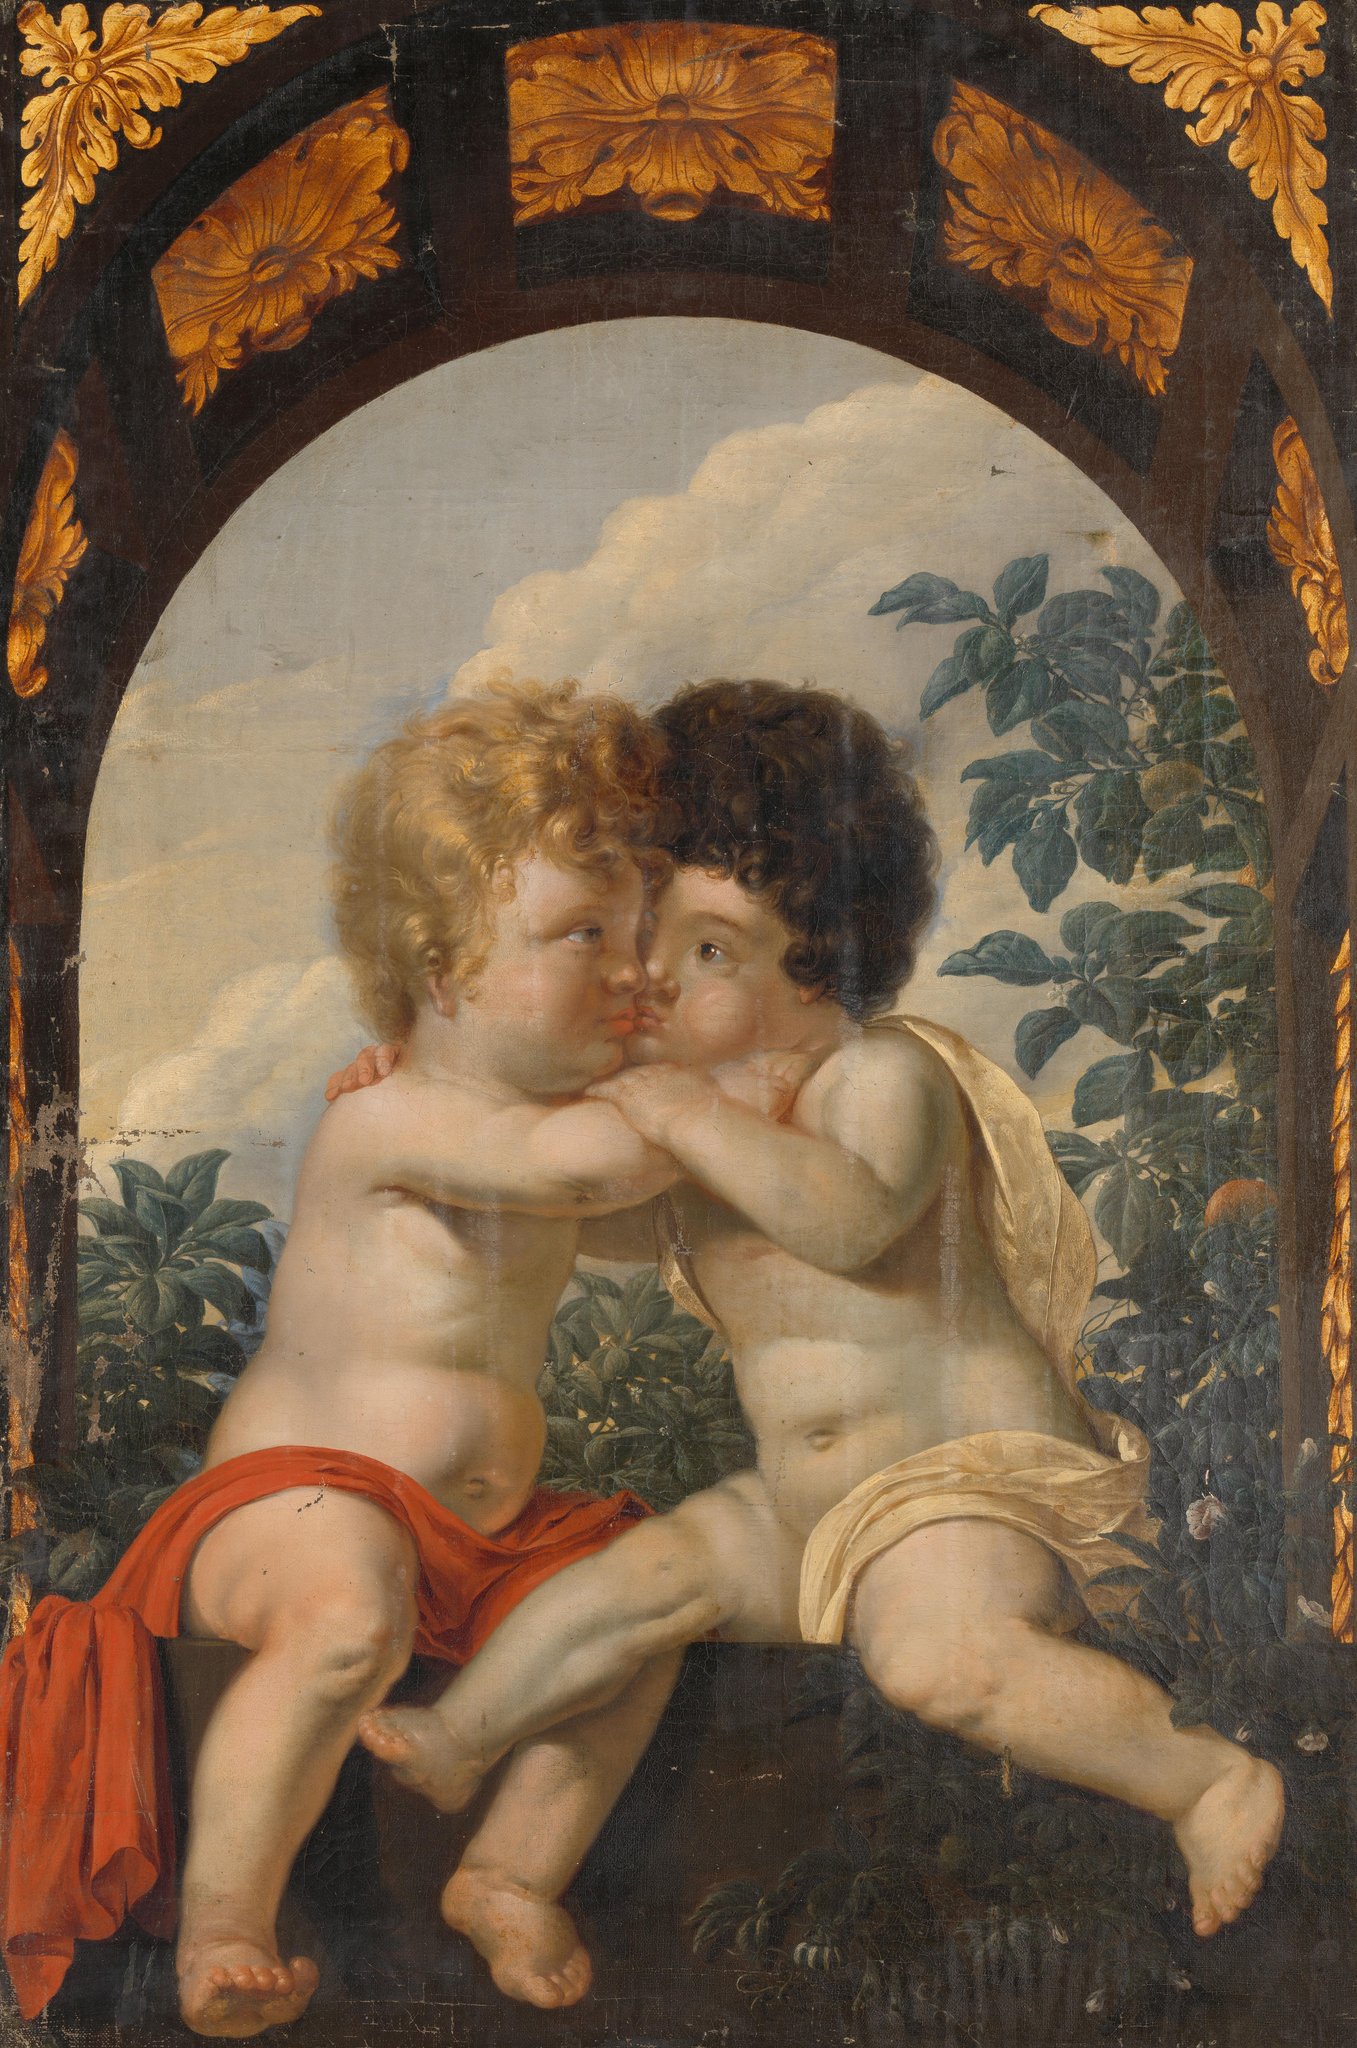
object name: painting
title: Christian Allegory with two Children Hugging each other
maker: Anonymous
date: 1650-1699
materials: canvas, oil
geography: northern netherlands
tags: charity, 'caritas'; 'carità' (ripa) ~ one of the three theological virtues, child, embracing each other, kissing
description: Christelijke allegorie met twee kinderen die elkaar omhelzen. Onderdeel van een reeks van vier decoratiestukken met op elk een christelijke allegorie met twee kindertjes (SK-A-1211/1214).